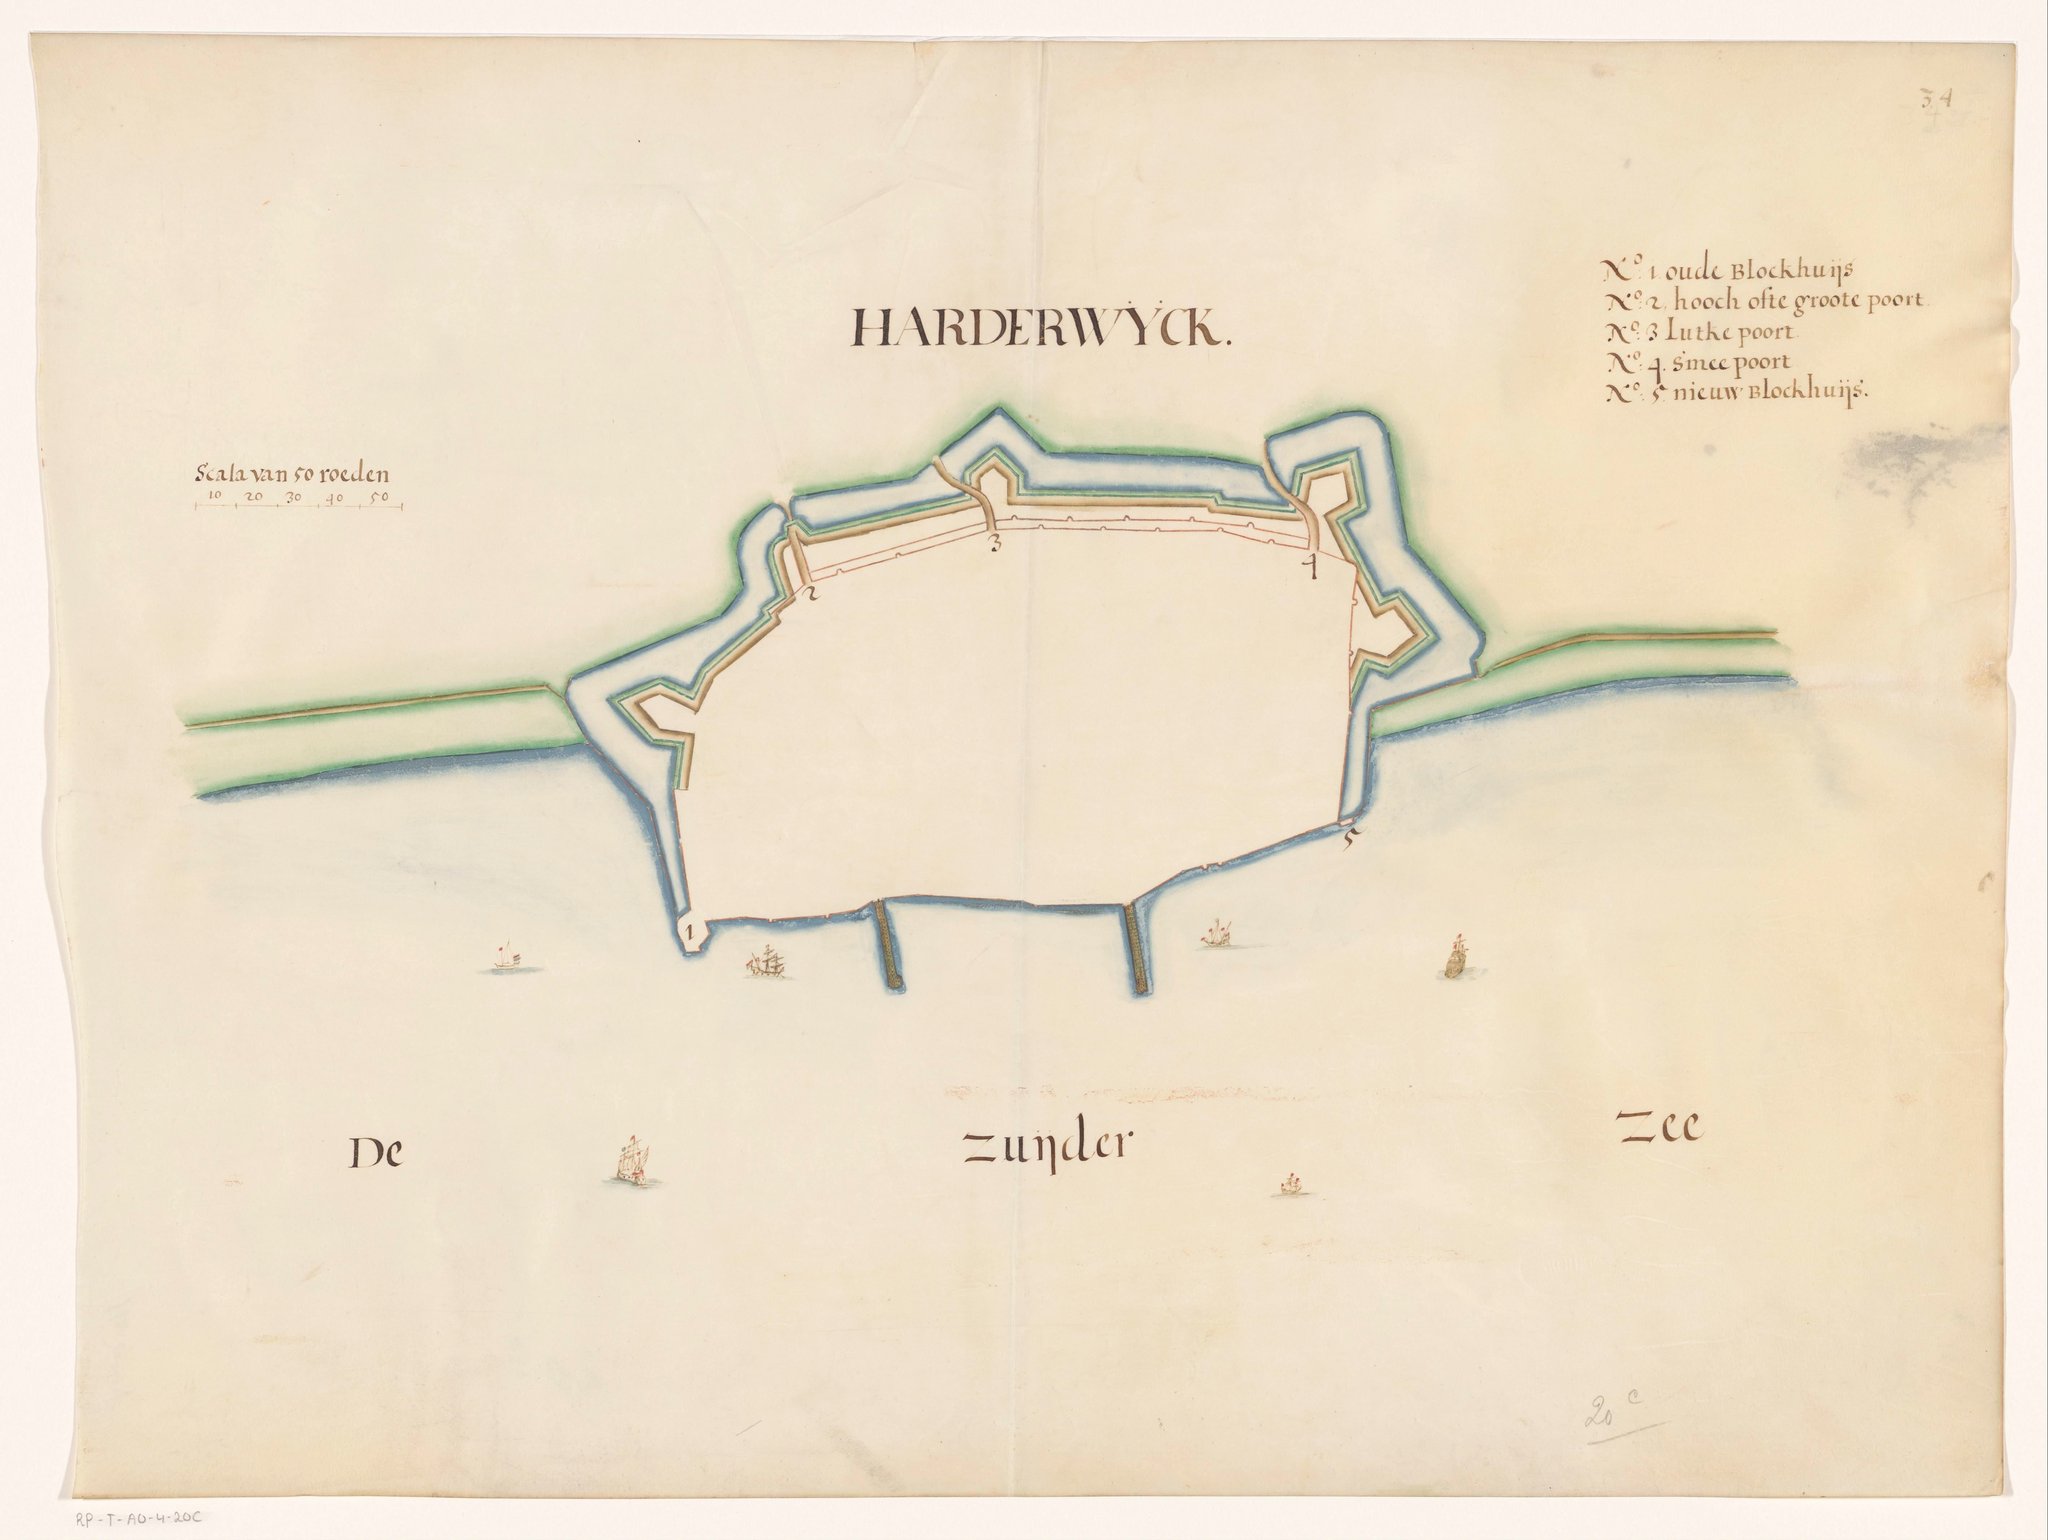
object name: area plan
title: Vestingplattegrond van Harderwijk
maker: Anonymous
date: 1650-1799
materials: ink, parchment, watercolor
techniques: brush, pen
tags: fortress, maps of cities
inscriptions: check stamp: ‘Archief Ministerie van Oorlog Afdeeling Genie’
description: Links een schaalstok: Scala van 50 roeden. Rechts een legenda.